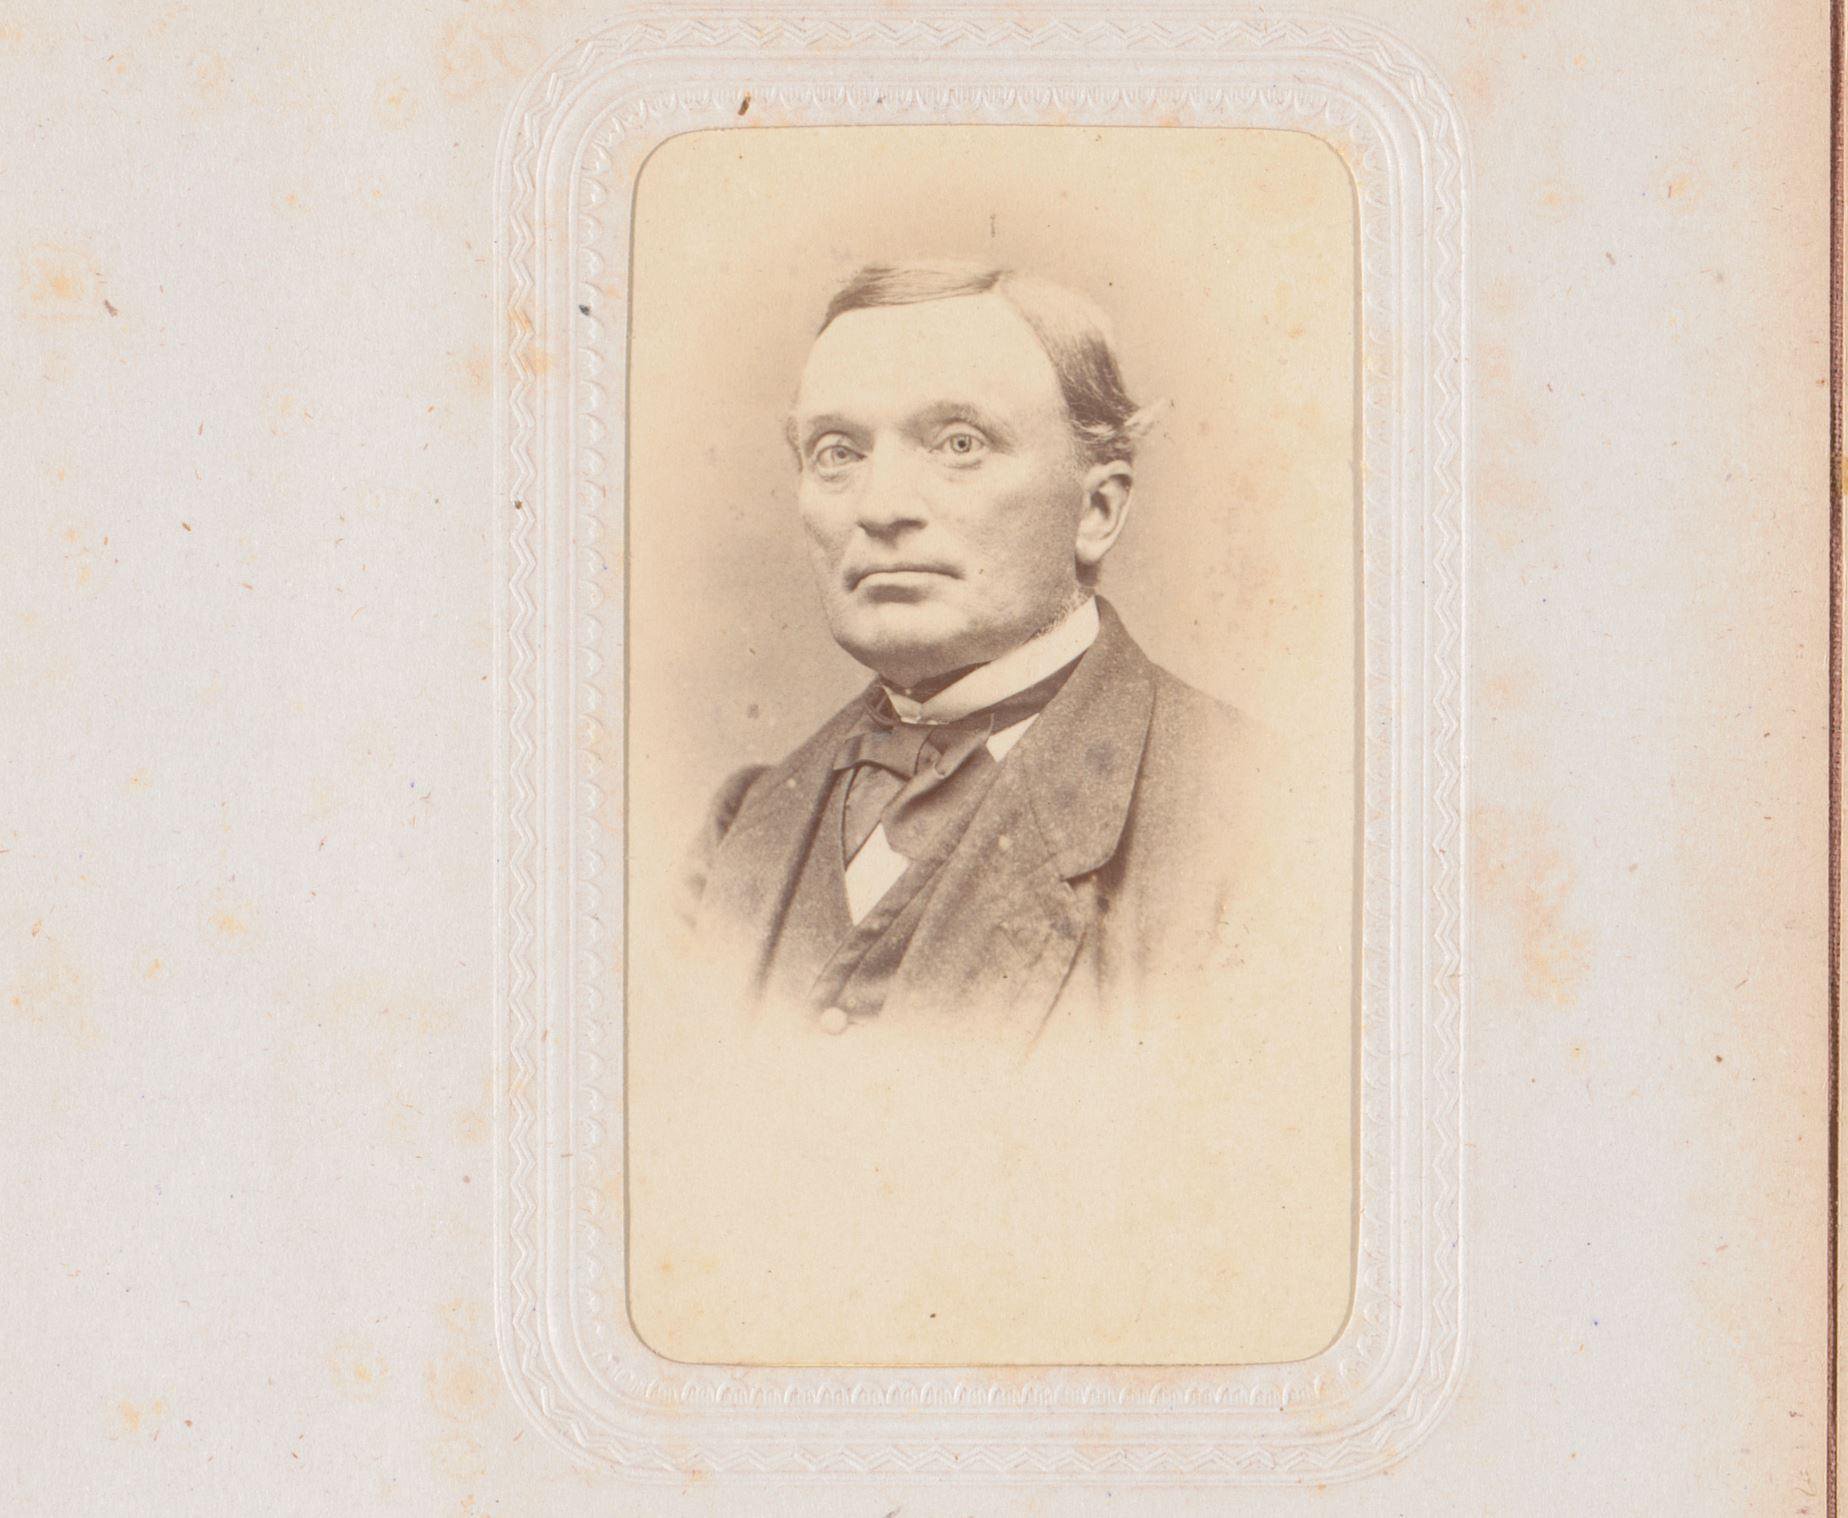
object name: album leaf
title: Portret van een man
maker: ed. radermacher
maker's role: fotograaf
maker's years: 1839-1908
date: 1864-1890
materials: cardboard, photographic support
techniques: albumen print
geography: rotterdam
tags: historical persons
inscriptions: inscription: ‘ED. RADERMACHER/ PHOTOGRAPH/ FIRMA/ (JANSSENS & RADERMACHER)/ KRUISKADE, HOEK KERKLAAN/ ROTTERDAM.’